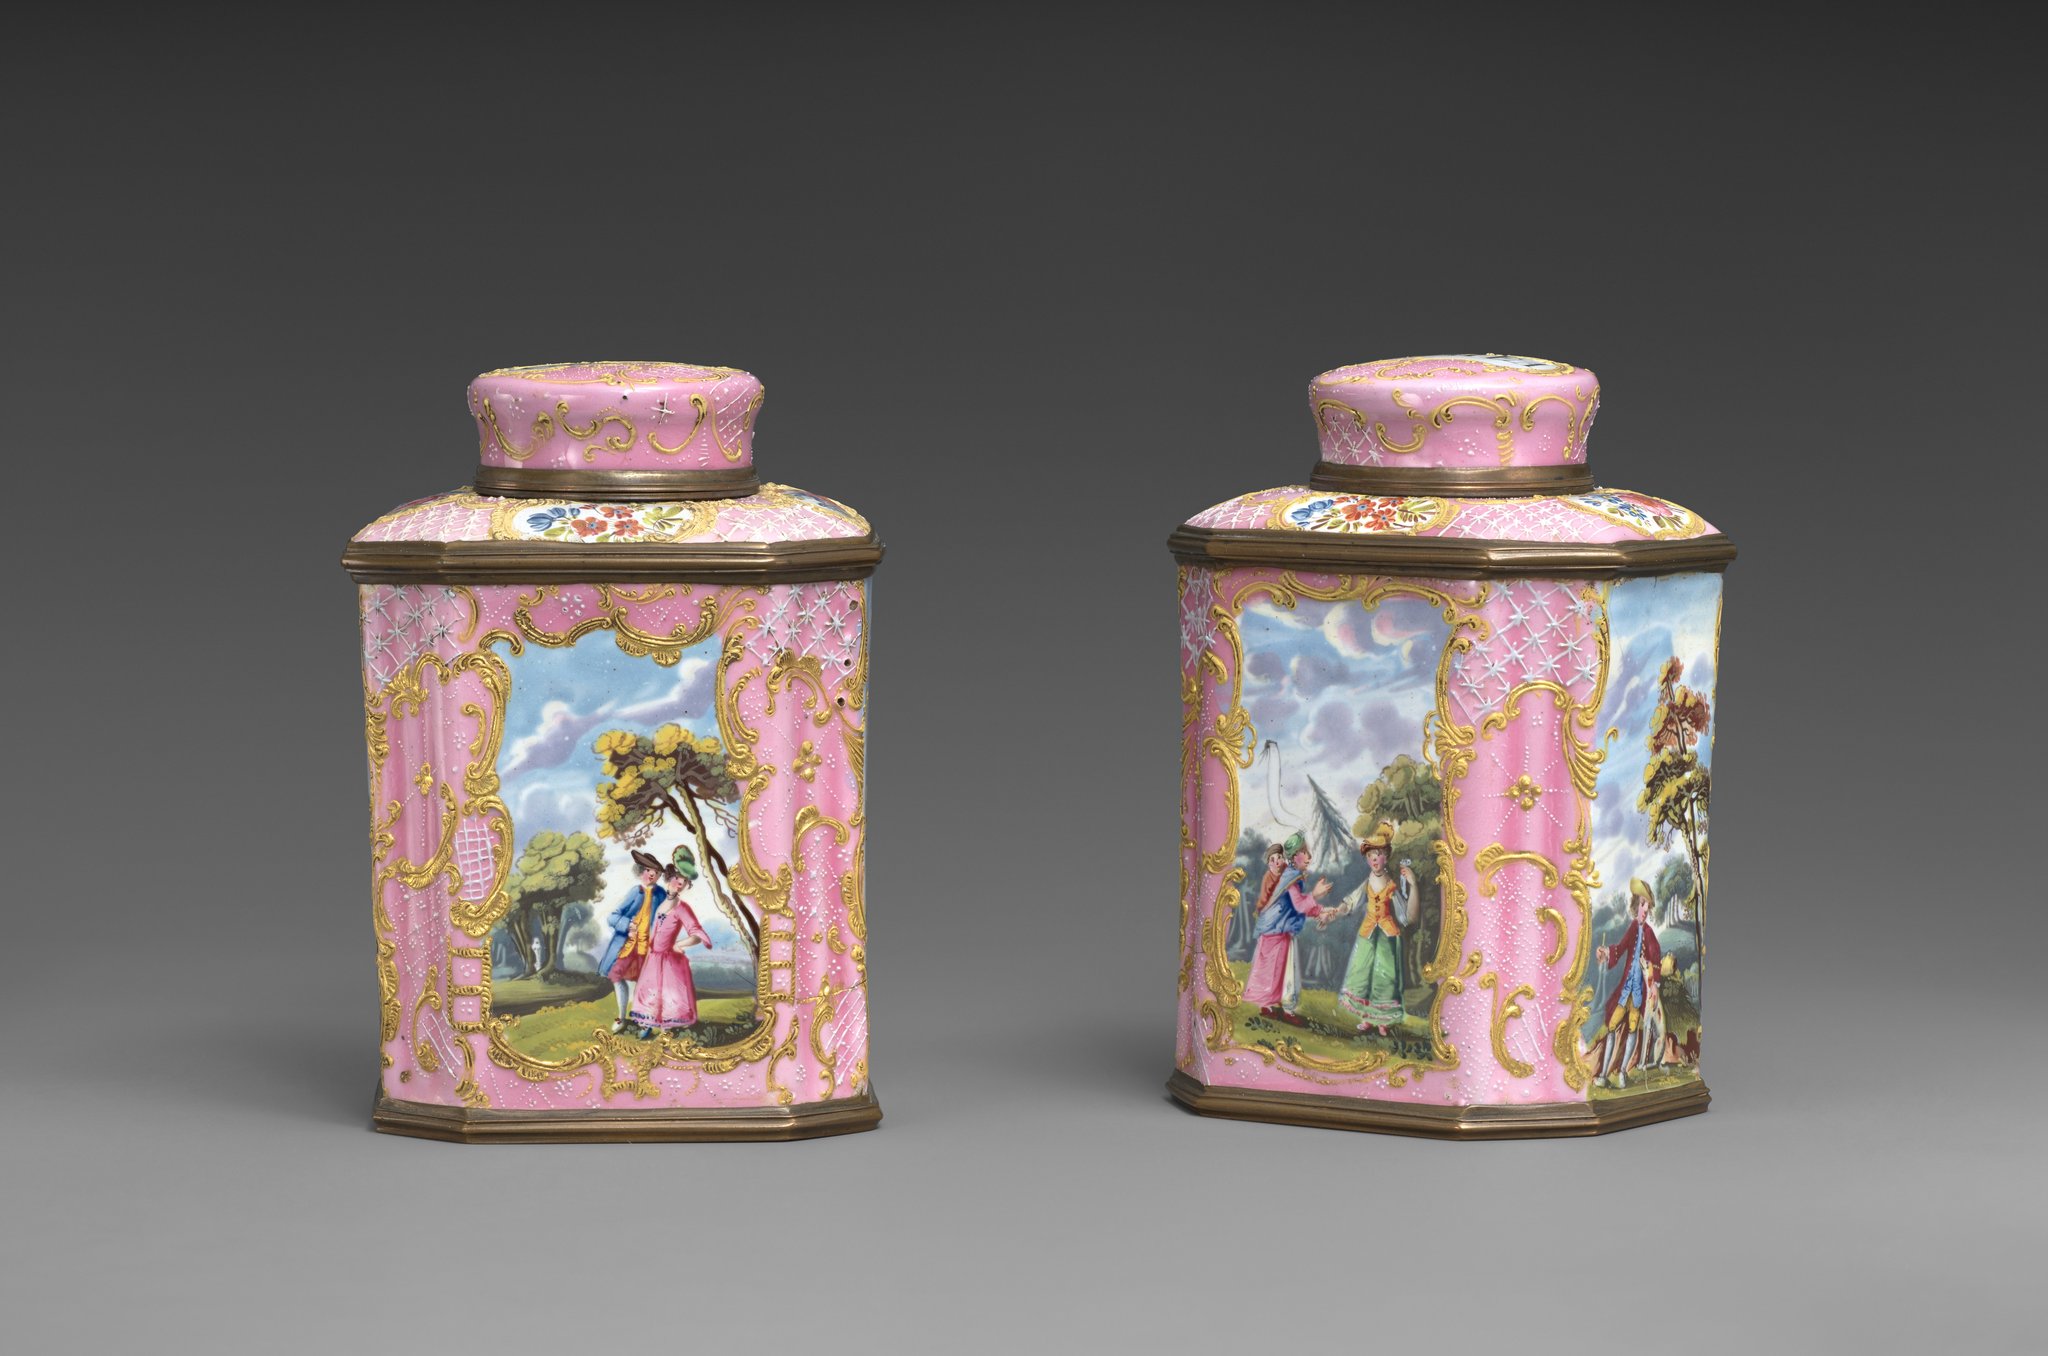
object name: tea caddy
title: Pair of tea caddies (part of a set)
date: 1765-1770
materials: copper, enamel